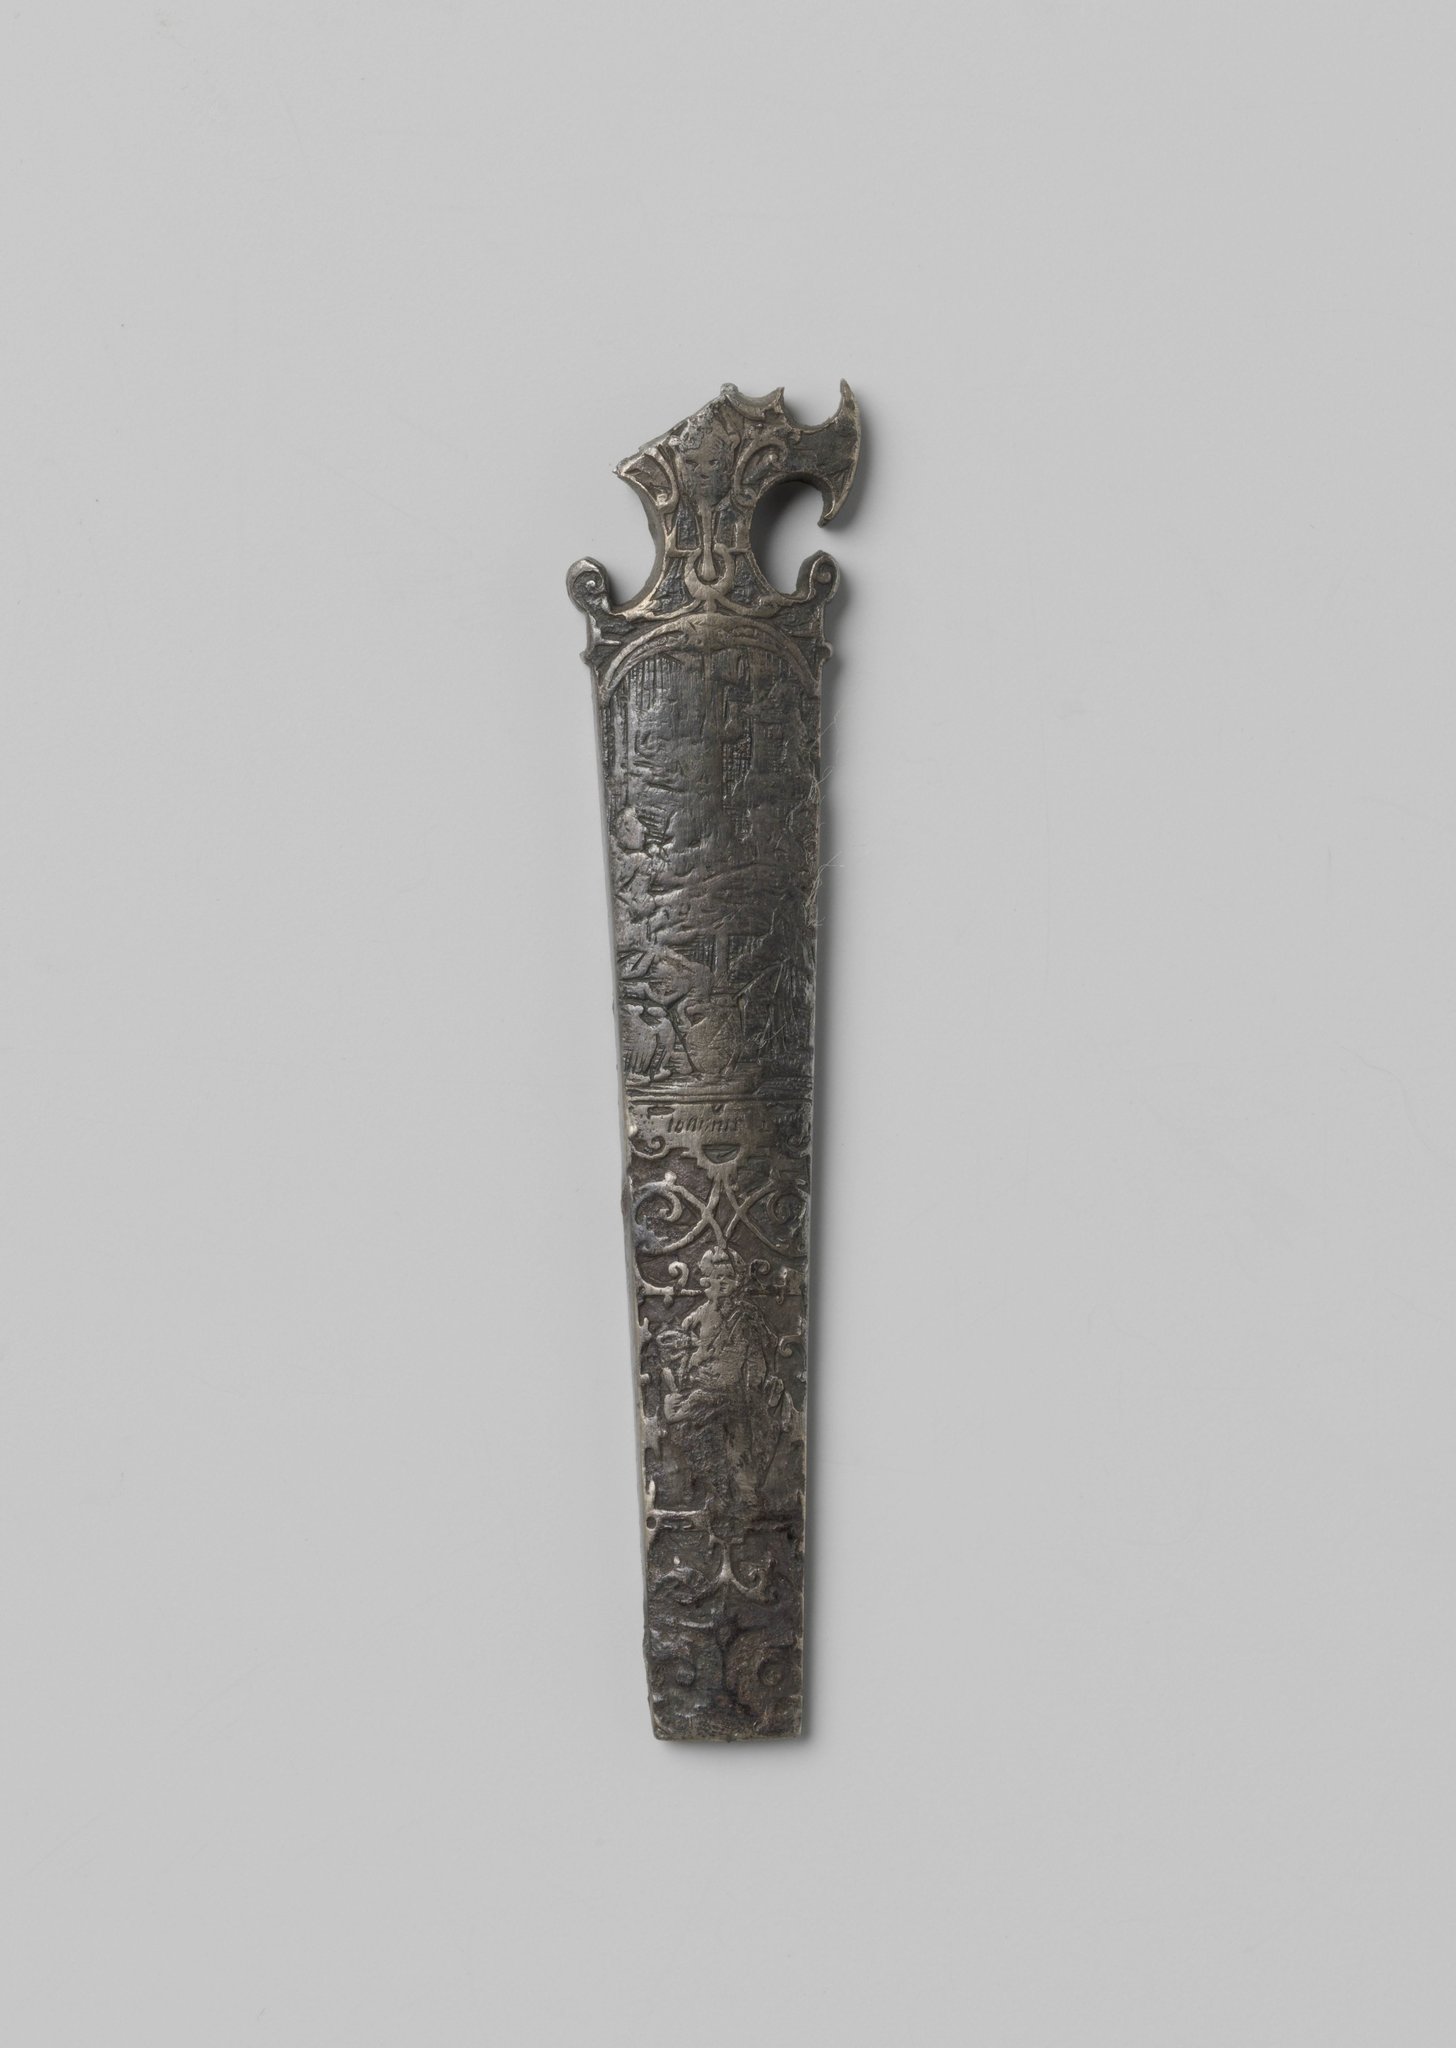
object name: knife handle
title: Heft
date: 1500-1600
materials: iron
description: De helft van een geciseleerd ijzeren messenheft, in de vorm van de z.g.n. zilveren messen van de Brij.